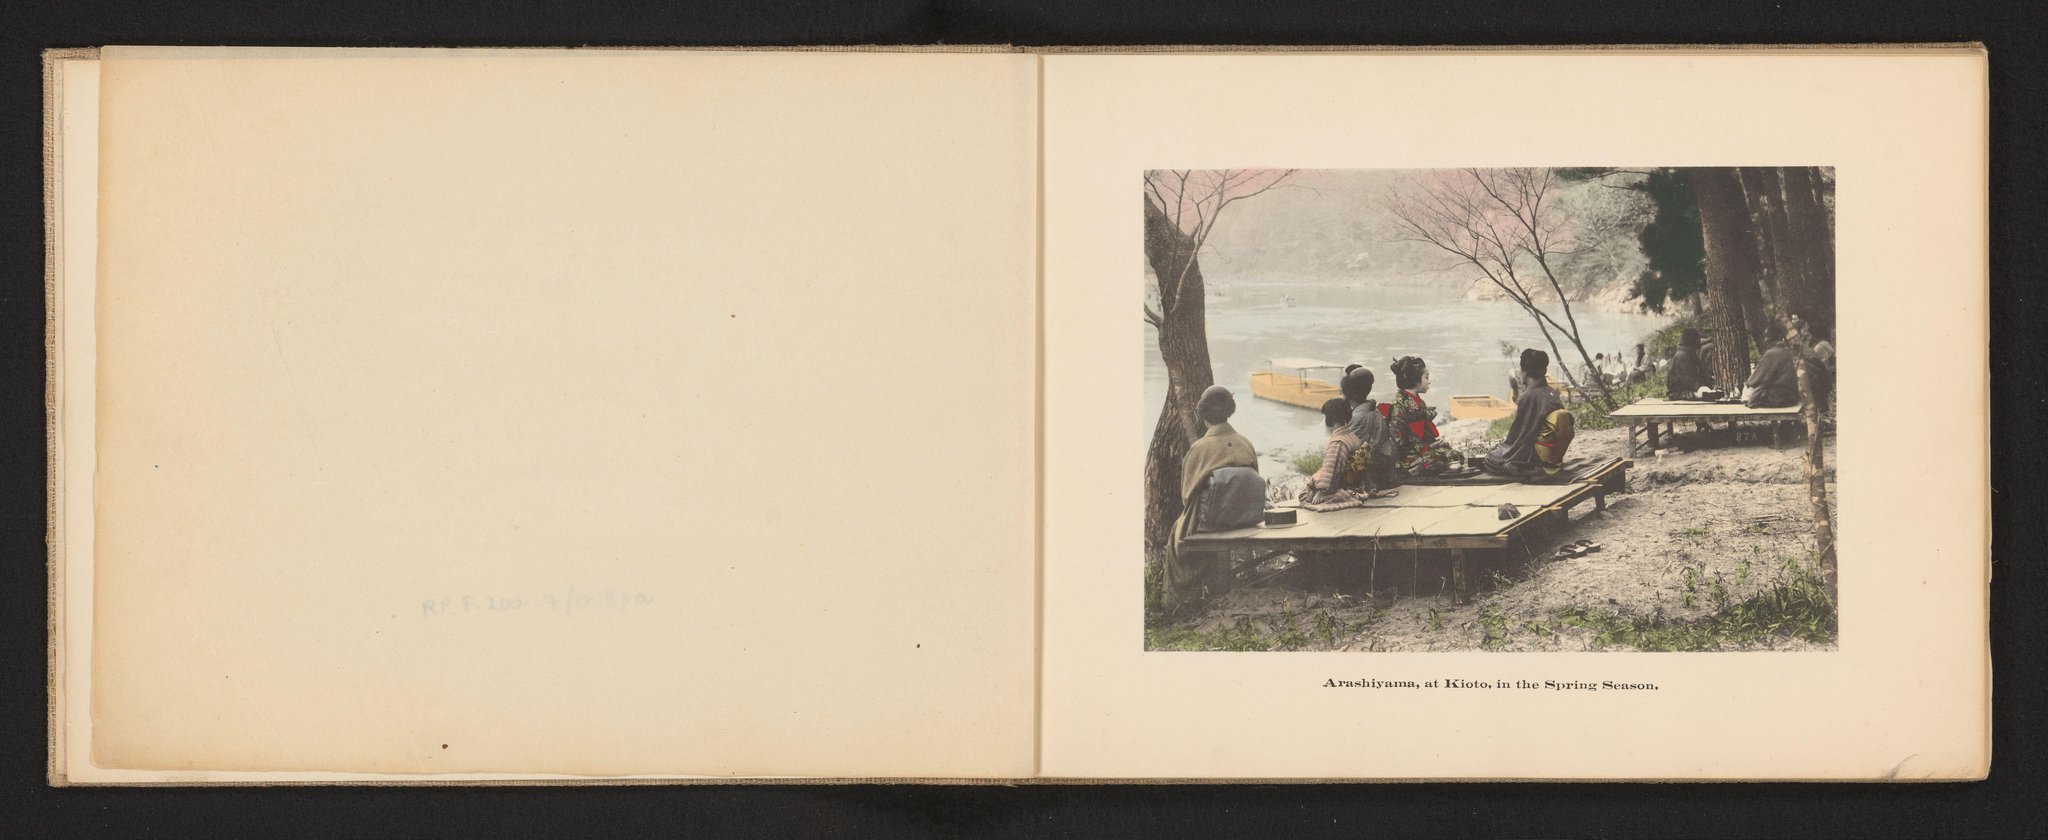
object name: photomechanical print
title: Mensen in traditionele Japanse kleding op platforms aan het water in Arashiyama bij Kyoto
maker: kōzaburō tamamura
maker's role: fotograaf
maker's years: 1856-1923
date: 1895-1905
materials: paper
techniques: photograph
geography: arashiyama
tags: river, folk costume, regional costume